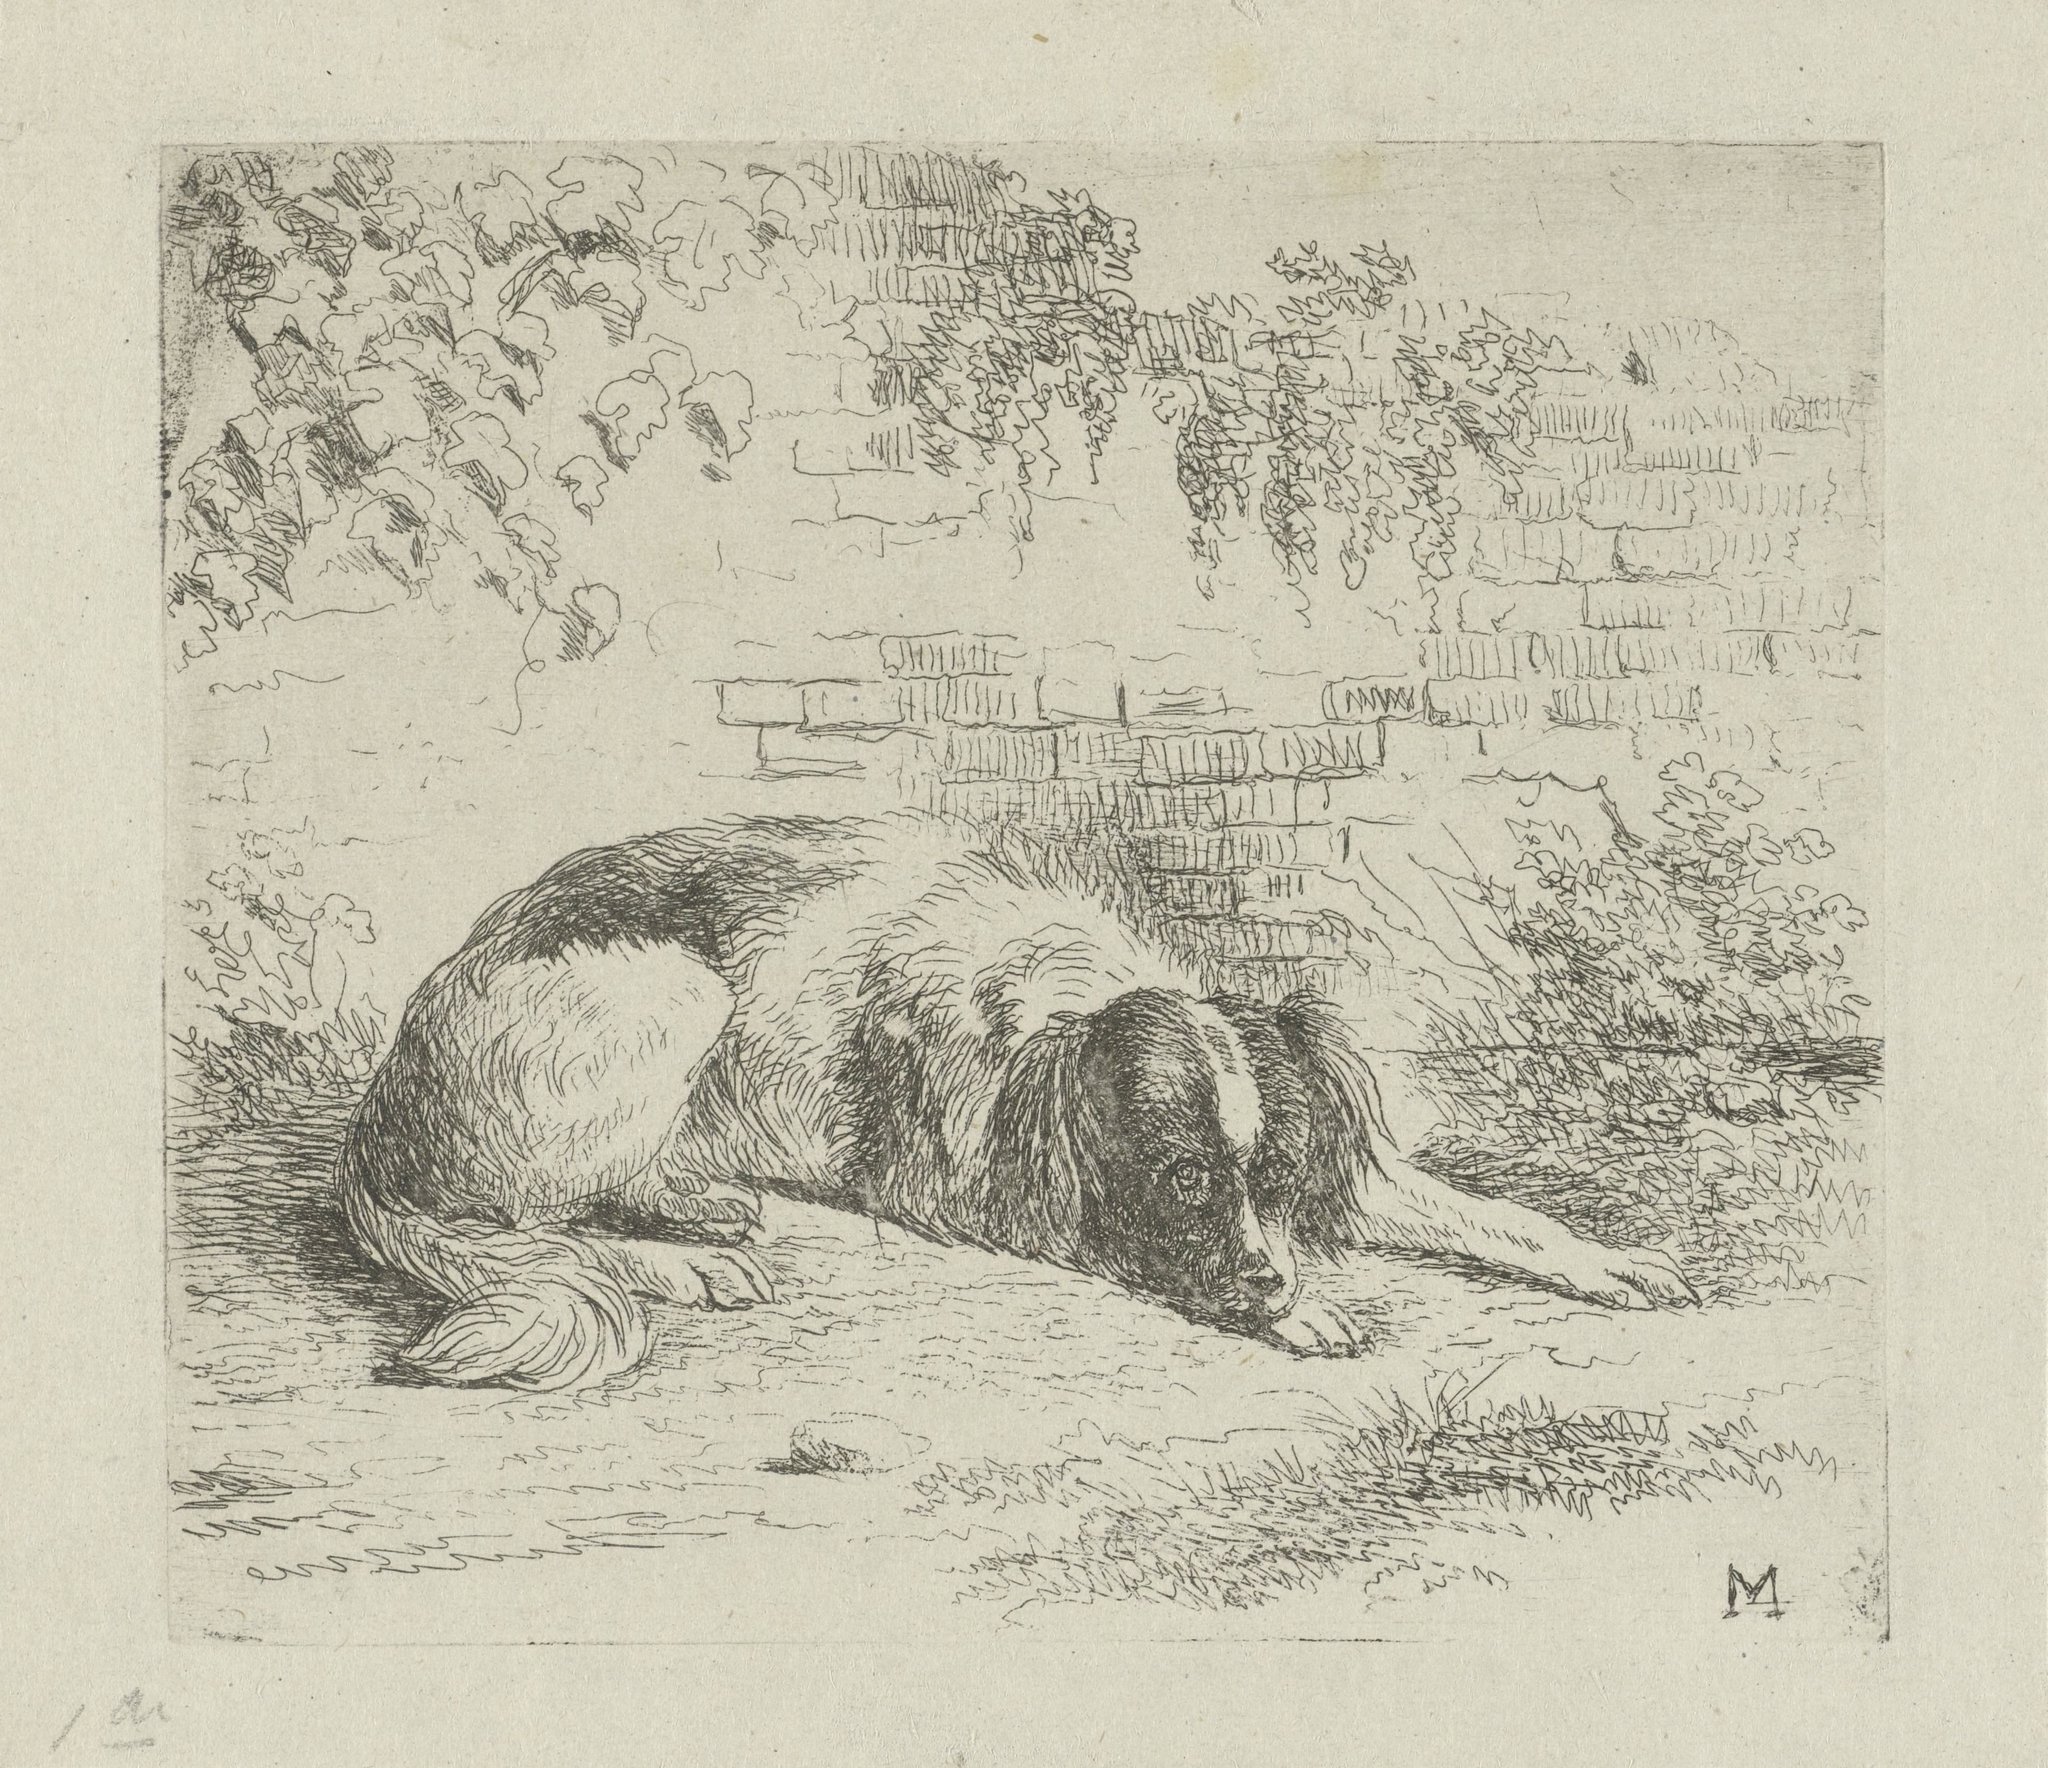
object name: print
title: Liggende hond voor een muurtje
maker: christiaan wilhelmus moorrees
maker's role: draughtsman, print maker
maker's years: 1801-1867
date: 1811-1867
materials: paper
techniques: etching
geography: netherlands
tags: dog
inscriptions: collector's mark: Lugt 2228